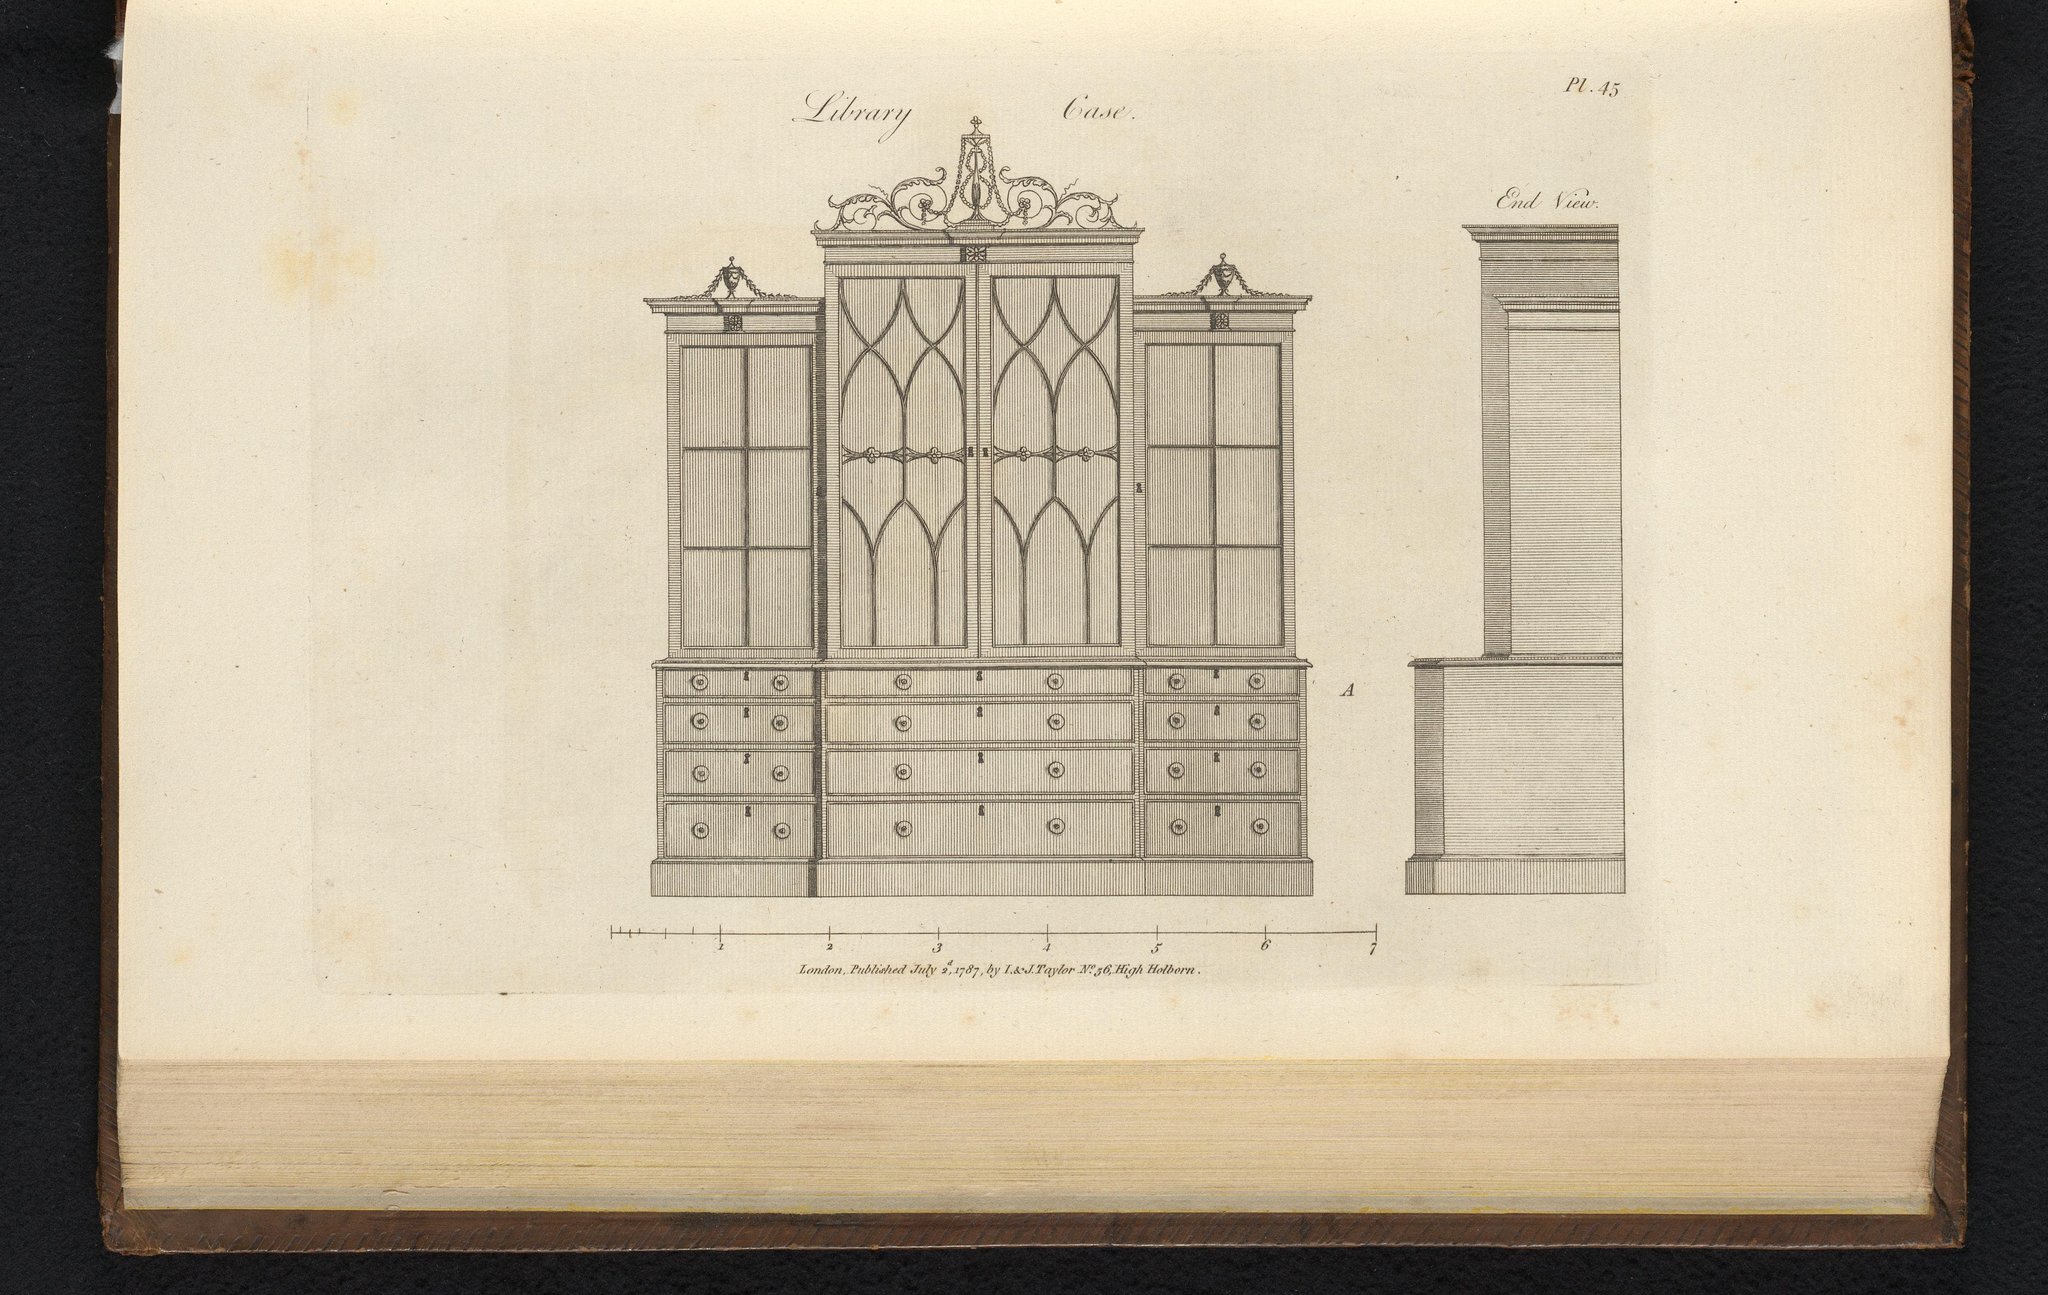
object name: print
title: Library Case / End View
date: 1787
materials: paper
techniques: engraving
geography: holborn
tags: bookcase, with doors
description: Genummerd: Pl. 45. Boekenkast gemerkt met: A. Schaalverdeling in de ondermarge. Prent maakt deel uit van een boek.